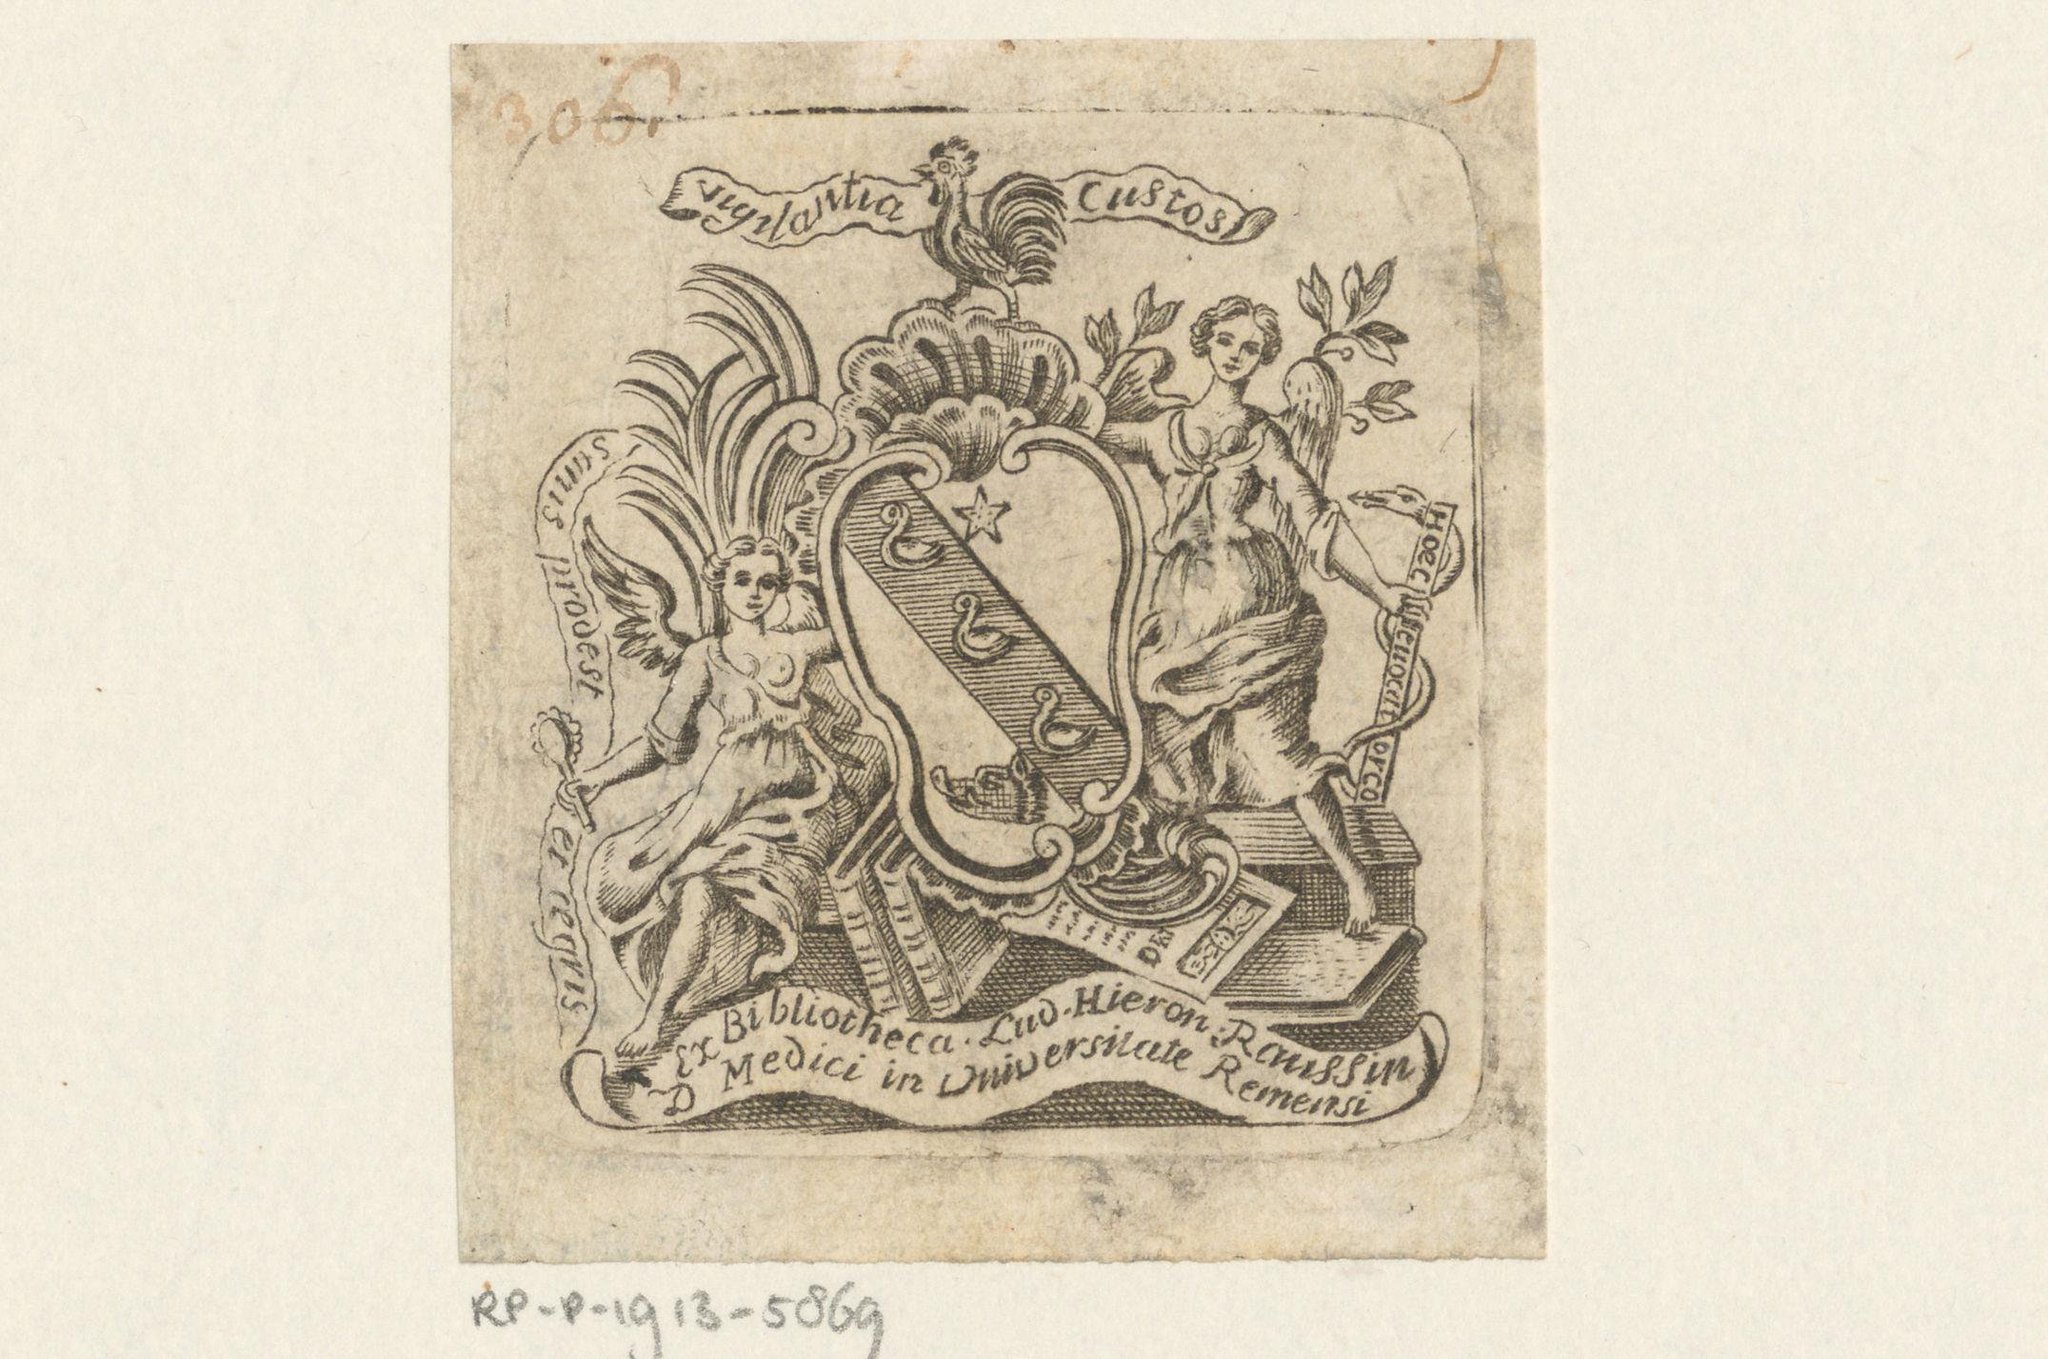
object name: bookplate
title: Ex biblitheca Lud. Hieron. Raussin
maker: Anonymous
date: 1731-1798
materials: paper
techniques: etching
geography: reims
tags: snakes, book, fowl (cock, hen, chicken, etc.), standing figure - aa - female human figure, armorial bearing, heraldry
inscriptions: inscription: ‘306.’, collector's mark: Lugt 2760, collector's mark: Lugt 2233